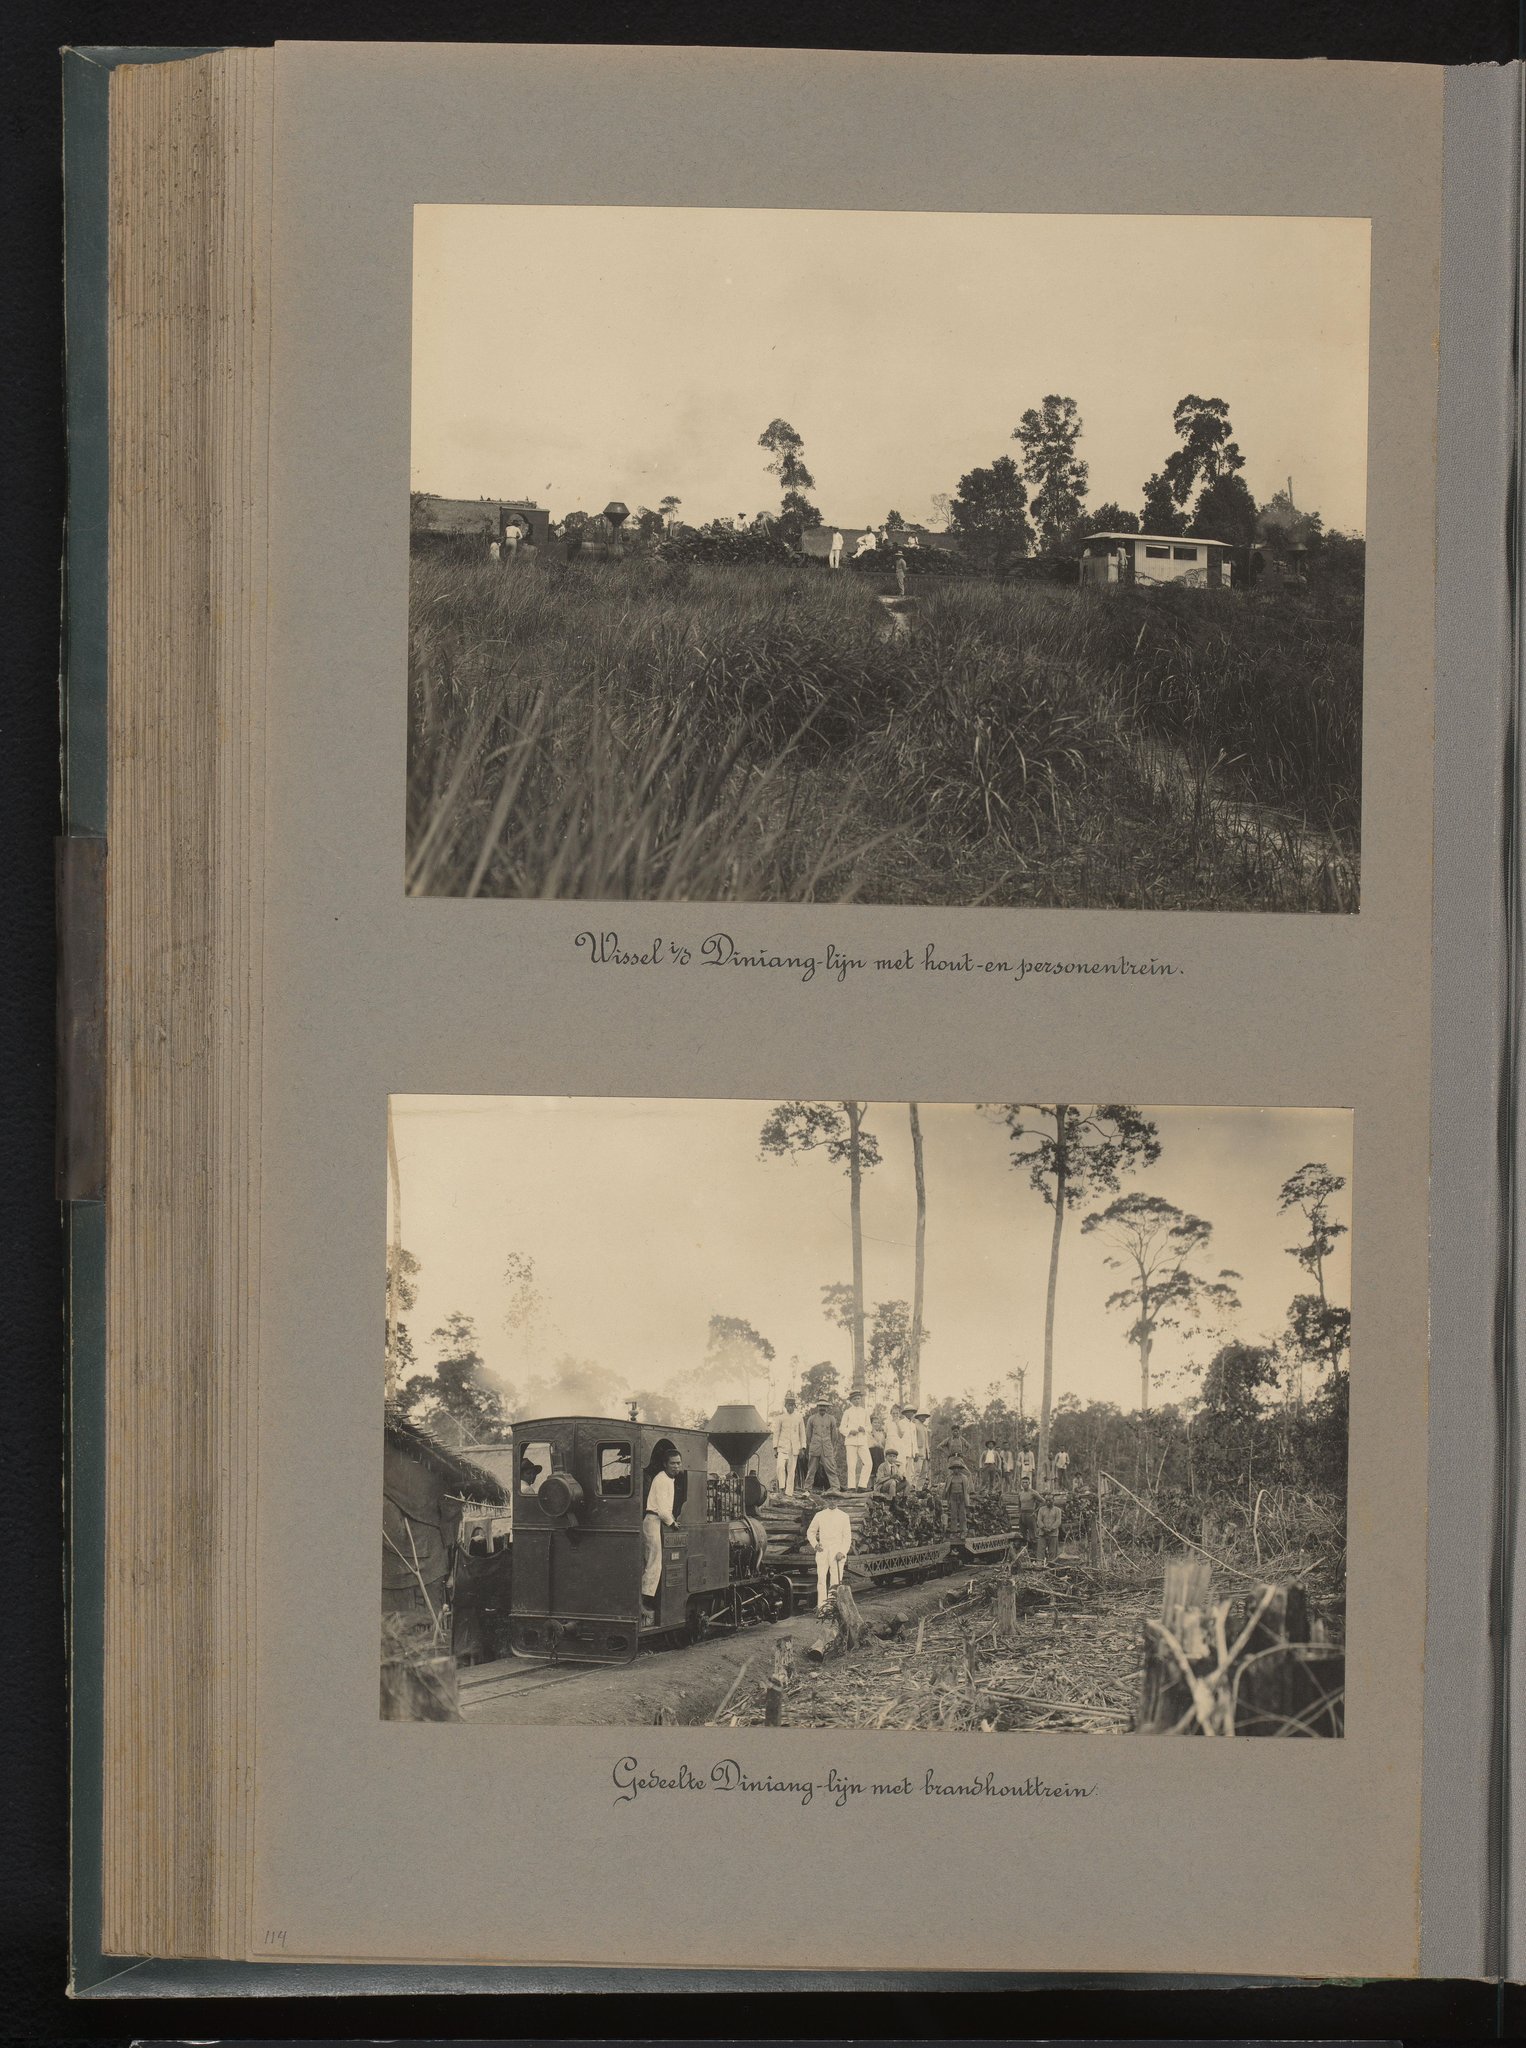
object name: album leaf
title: Hout- en personentrein van de Banka-tinwinning te Soengeiliat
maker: Anonymous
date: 1914-1919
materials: cardboard, photographic support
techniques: gelatin silver print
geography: bangka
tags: robert julius boers, colonial system, mining, railway, tramway; rack railway (+ propulsion of vehicle, ship, etc. by steam), clearing ~ forest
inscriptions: inscription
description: Albumblad met 2 foto's van de brandhout- en personentrein van de Banka-tinwinning te Soengeiliat. Onderdeel van het fotoalbum aangeboden aan Robert Julius Boers bij zijn vertrek naar Nederland in 1919 door het personeel van de Banka-tinwinning.